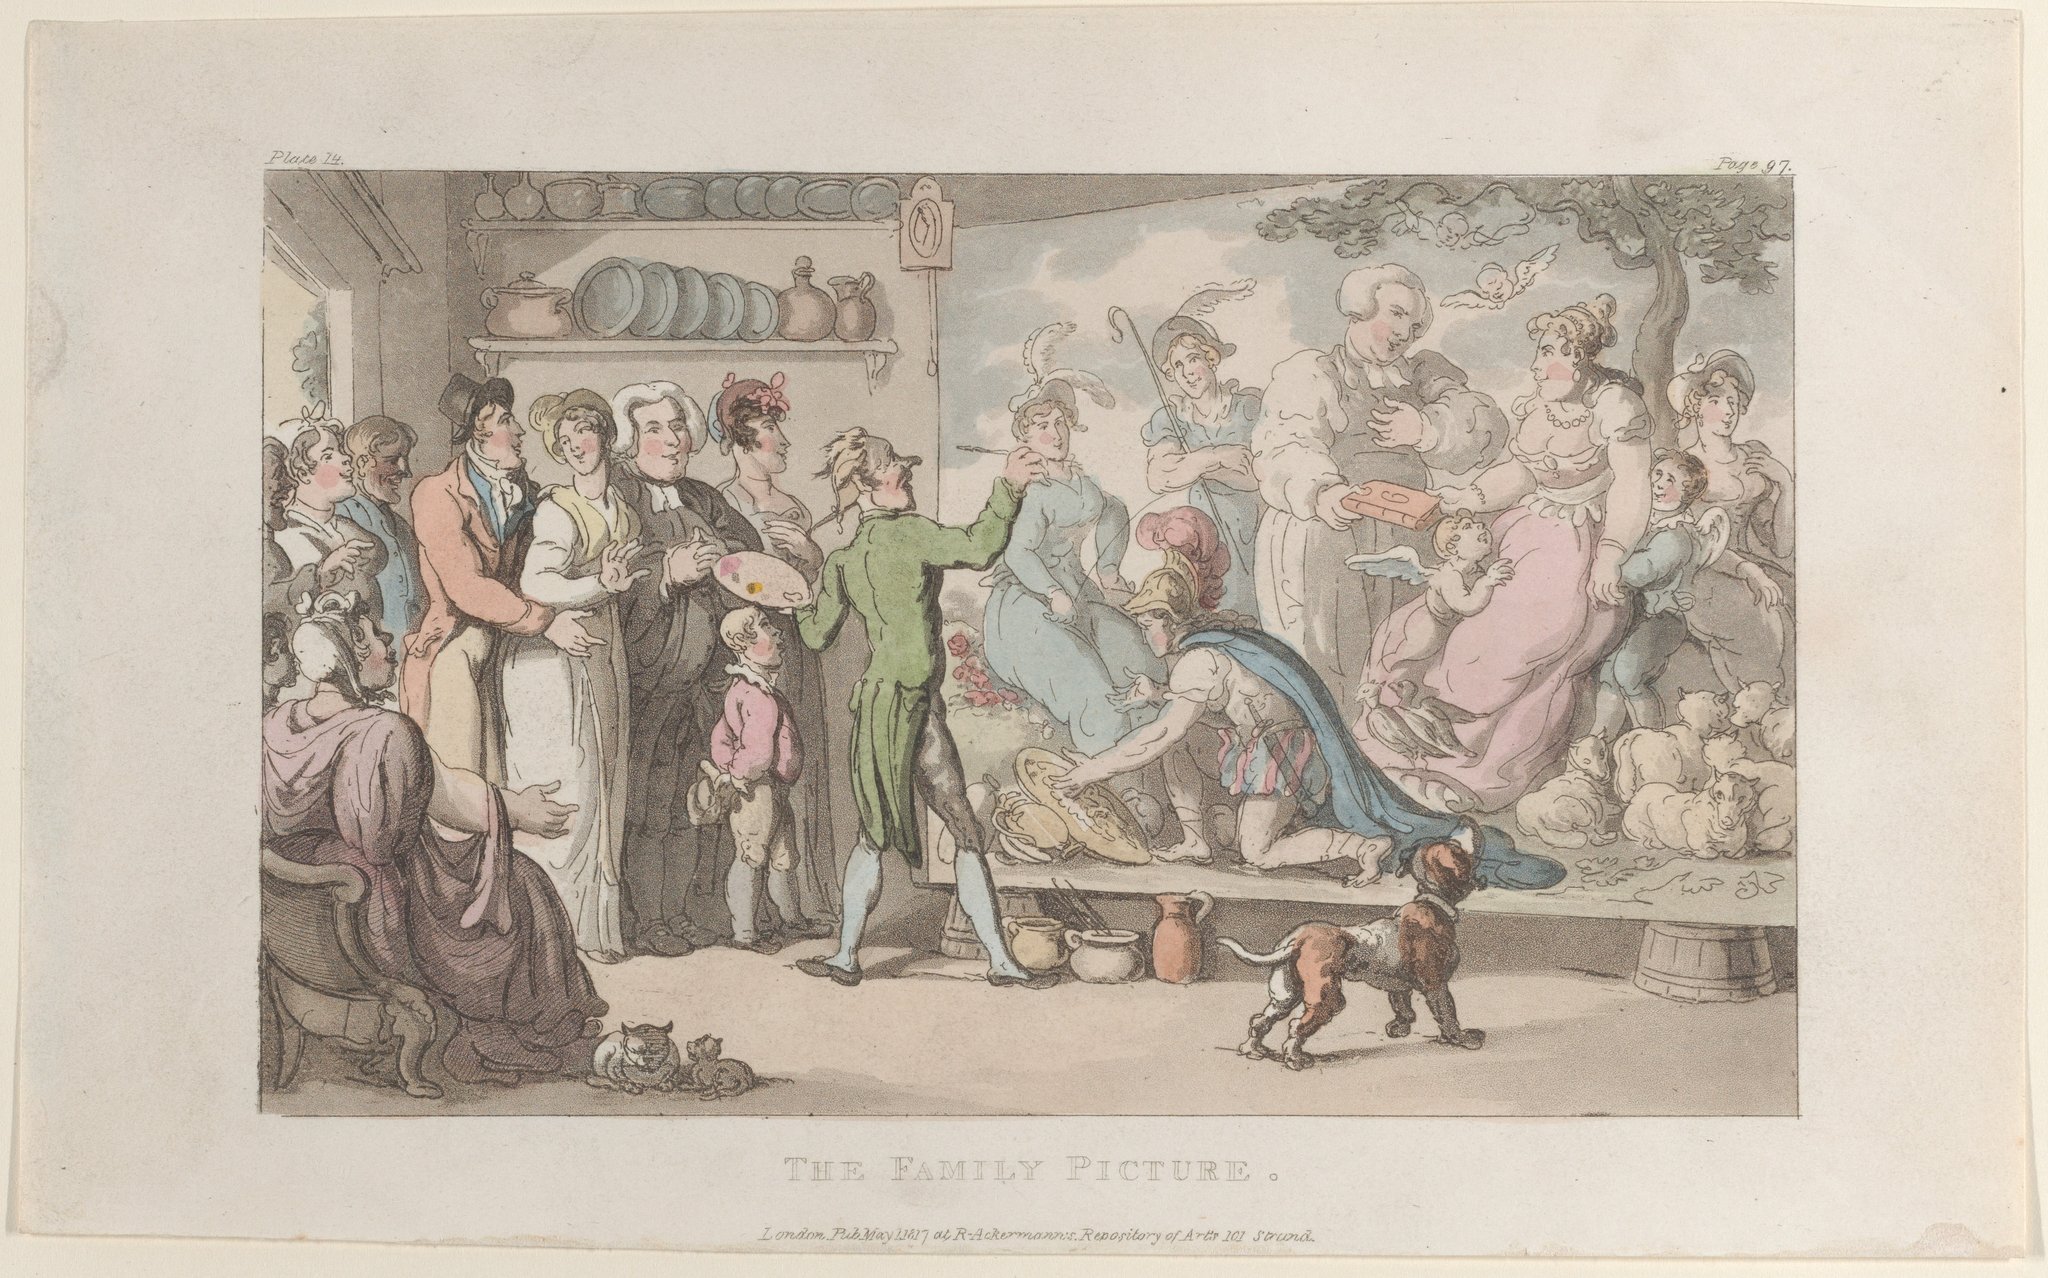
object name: print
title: The Family Picture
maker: thomas rowlandson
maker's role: artist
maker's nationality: british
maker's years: 1757-1827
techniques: aquatint, etching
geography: london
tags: painting,men,women,dogs,artists